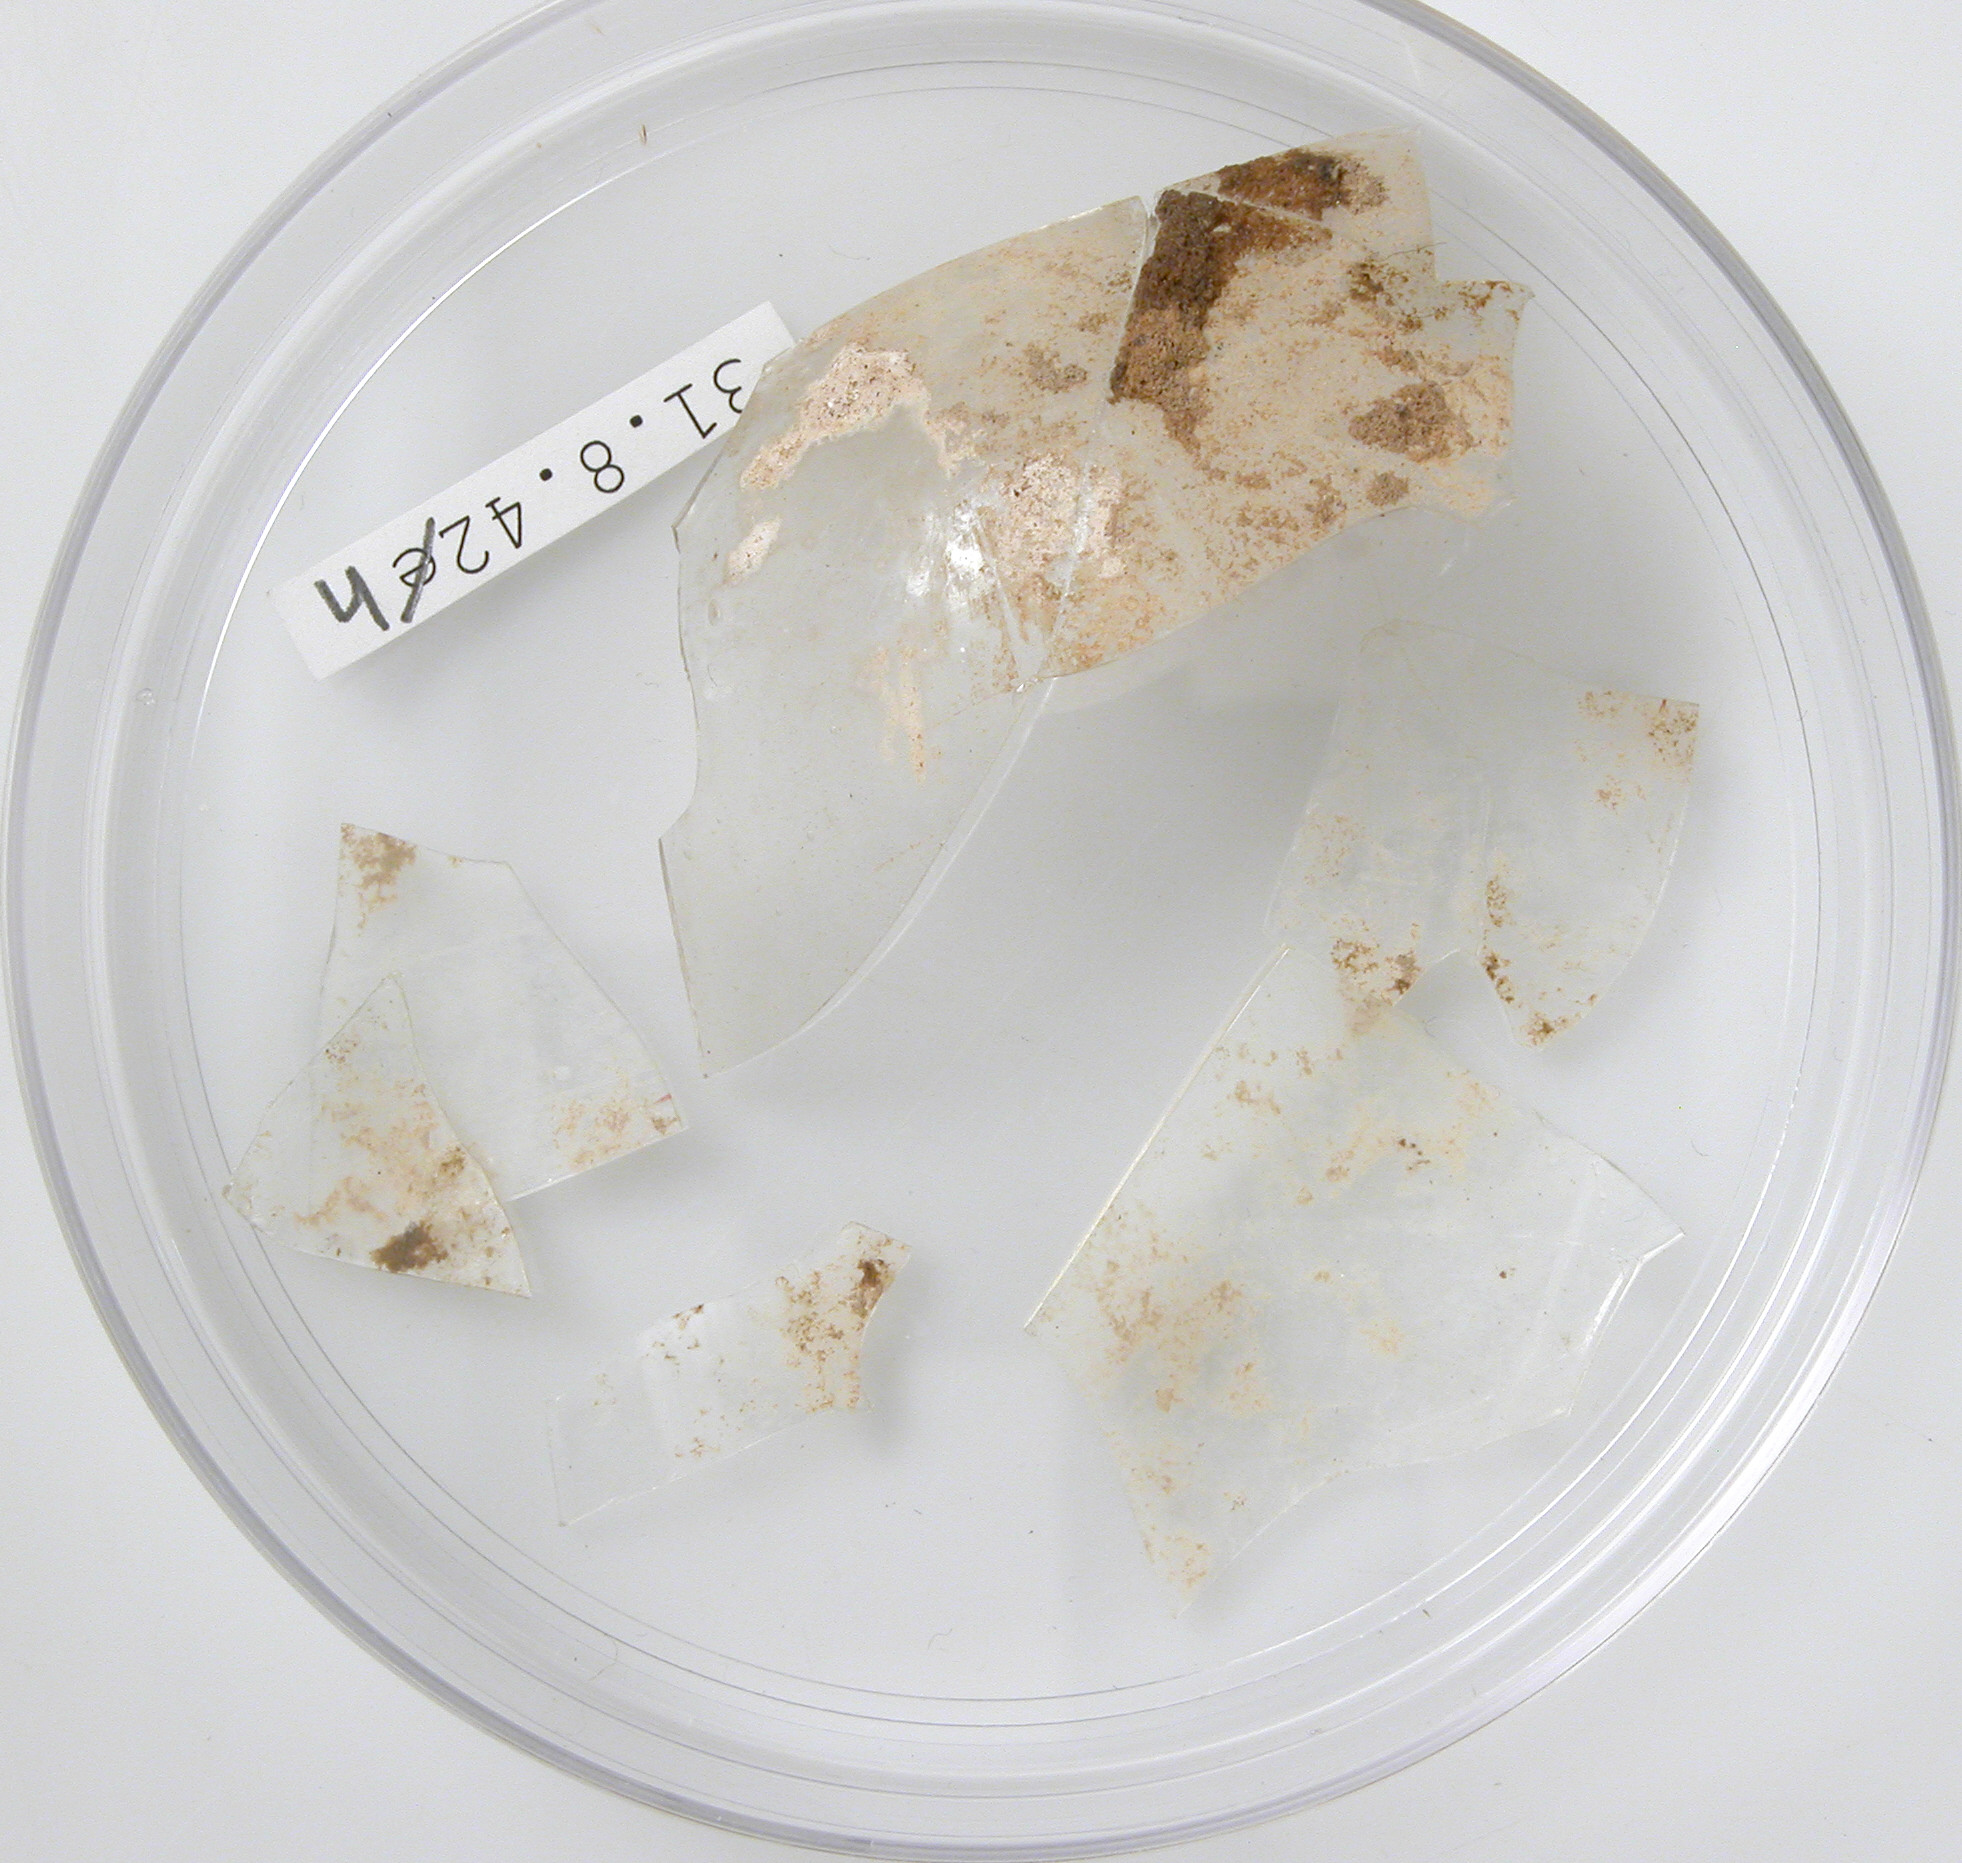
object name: fragment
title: Glass Fragments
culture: coptic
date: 301-400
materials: glass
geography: egypt